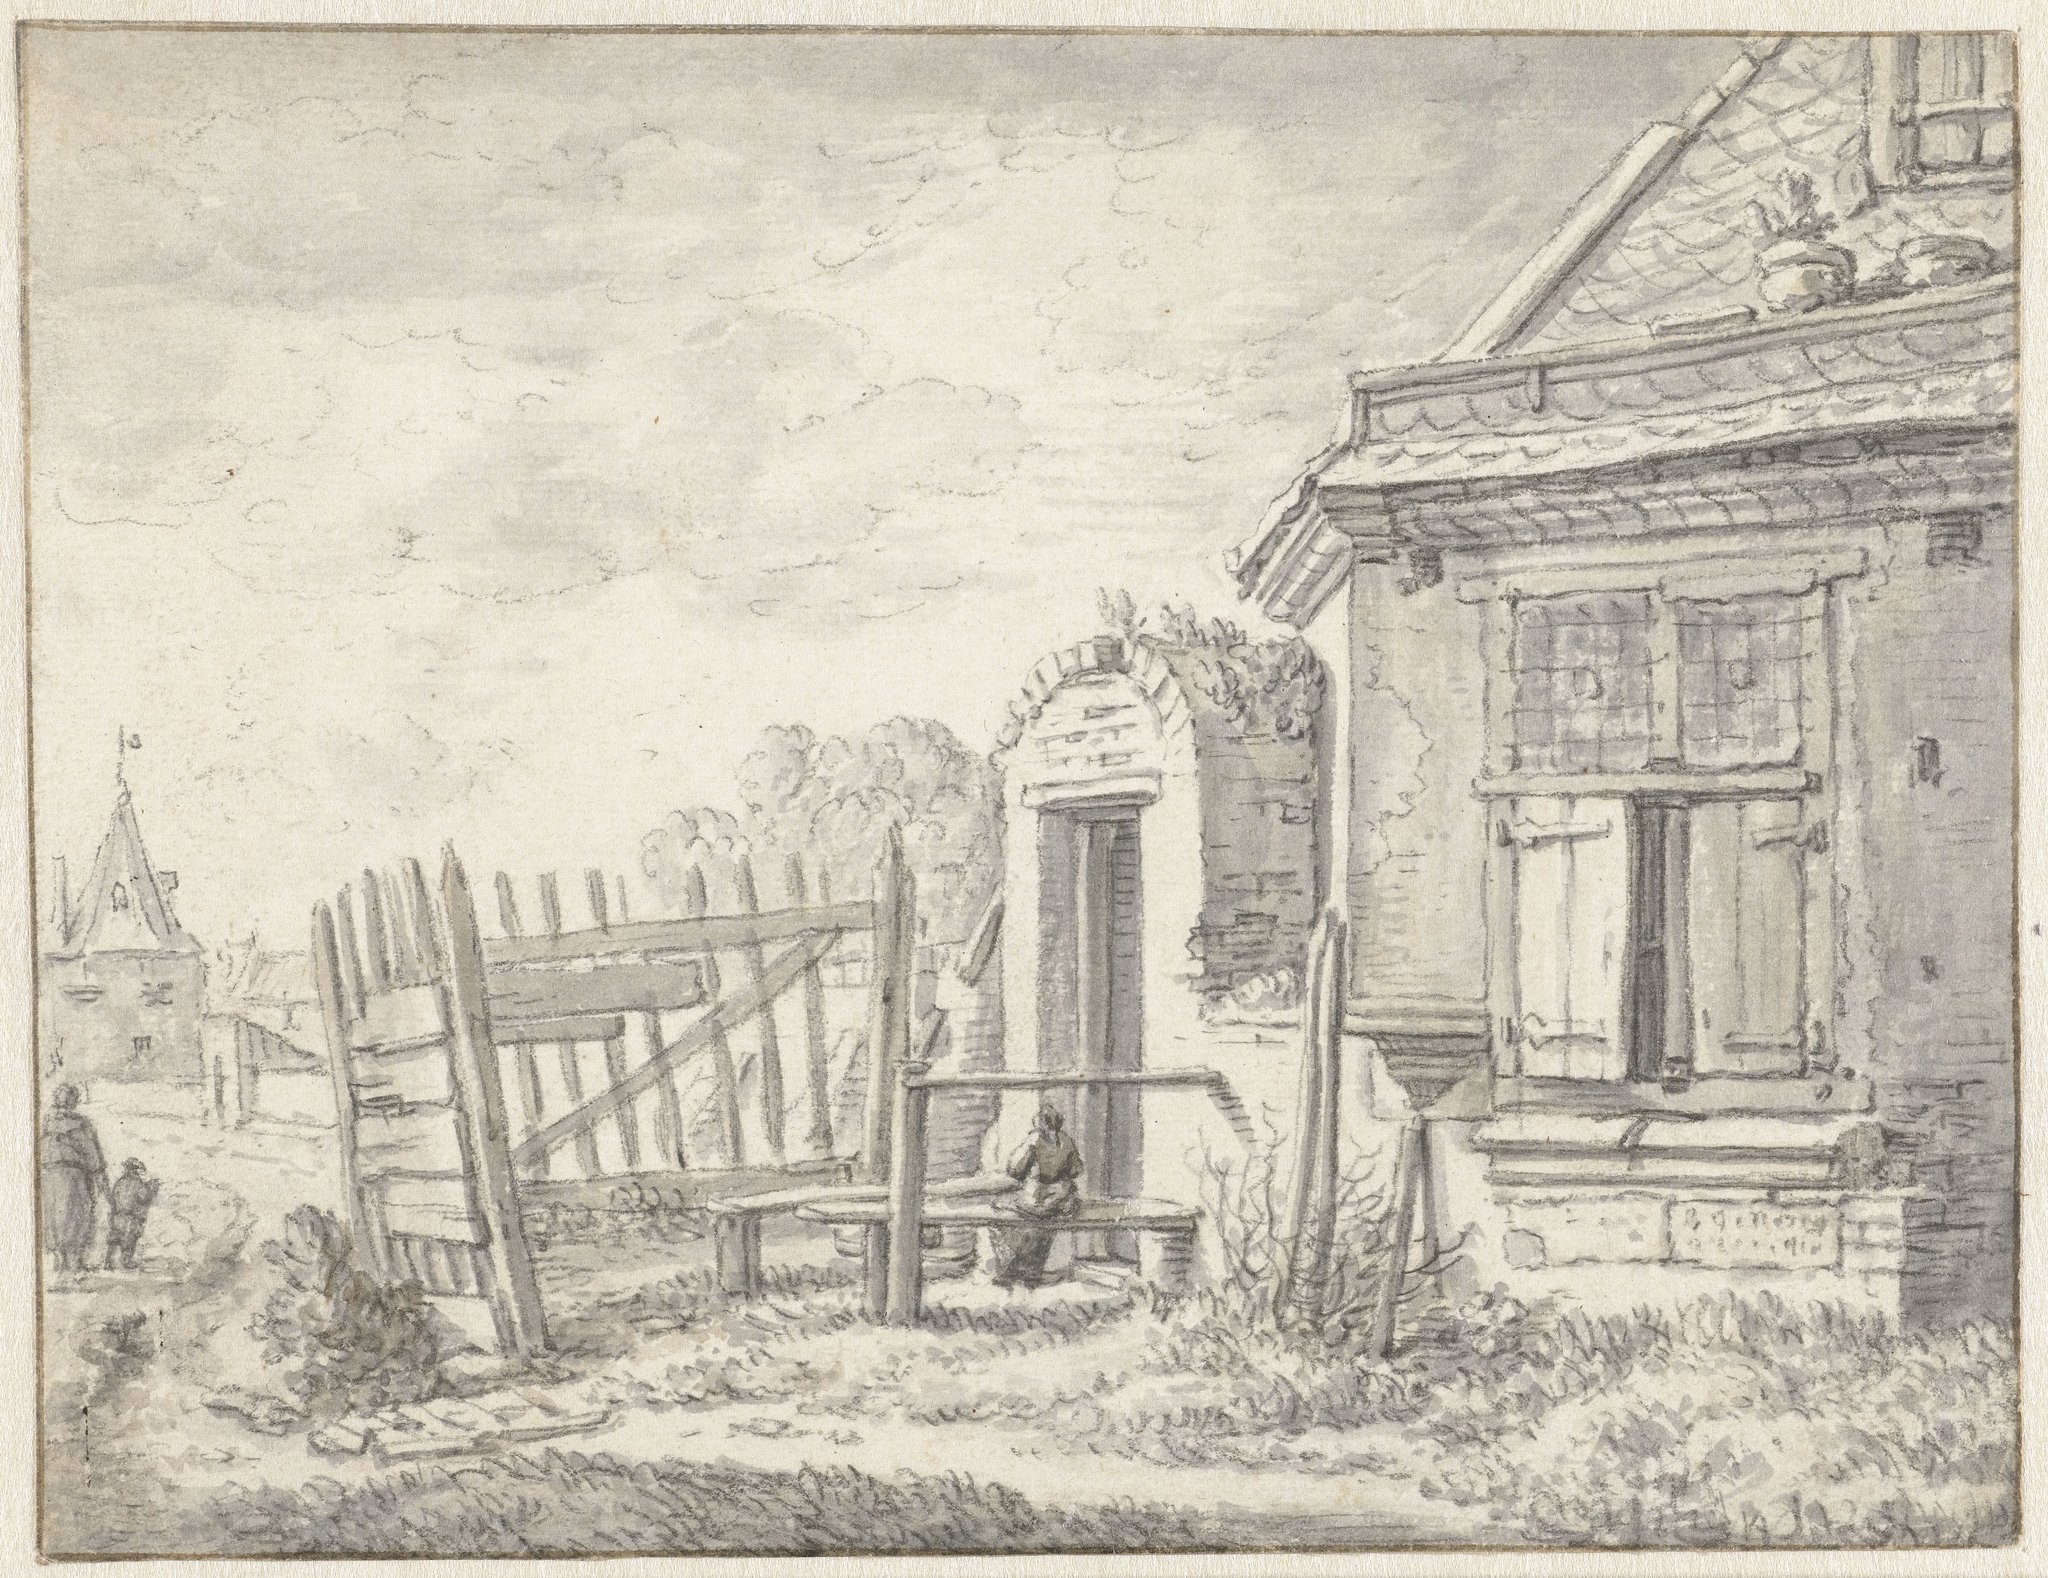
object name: drawing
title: Gezicht te Utrecht op de stadswal bij de Wittevrouwenpoort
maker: herman saftleven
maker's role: draughtsman, painter, print maker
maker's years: 1609-1685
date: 1619-1685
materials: chalk, paper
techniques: brush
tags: city-gate, utrecht